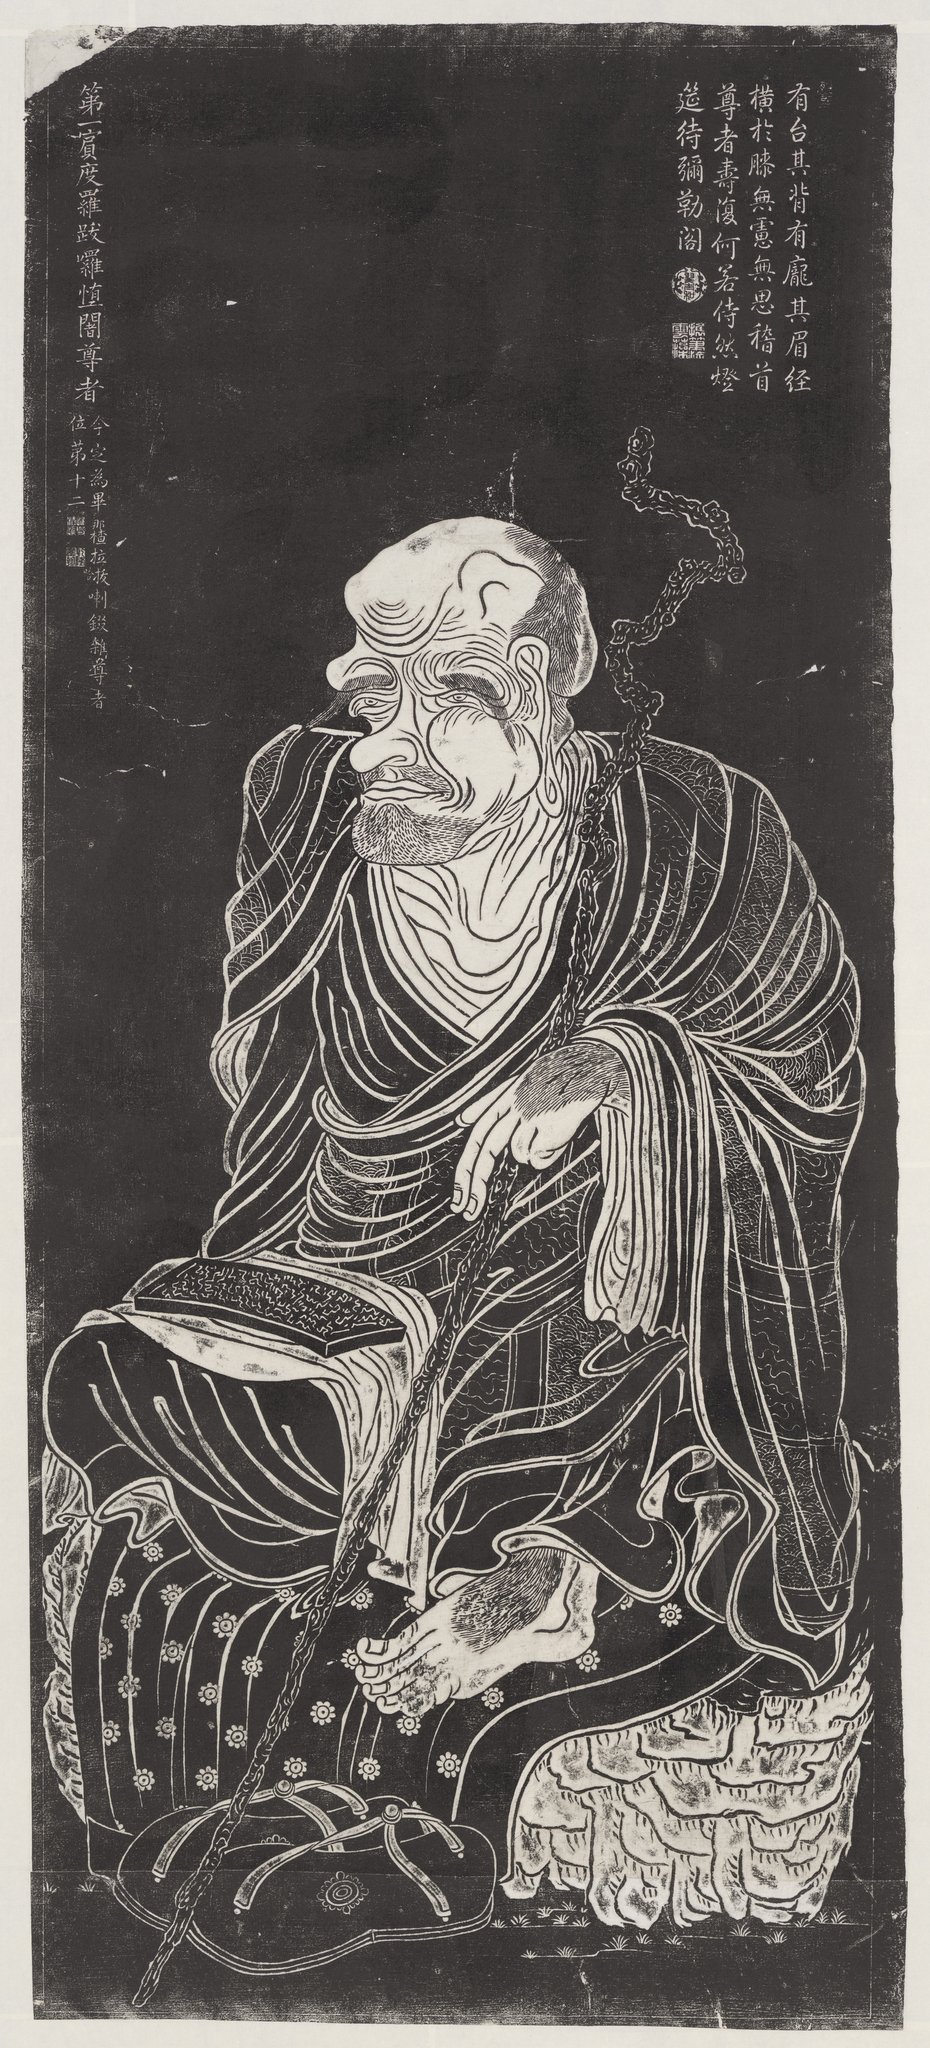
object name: rubbing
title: Luohan, after a set attributed to Guanxiu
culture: chinese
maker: unidentified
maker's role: artist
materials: ink, paper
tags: men